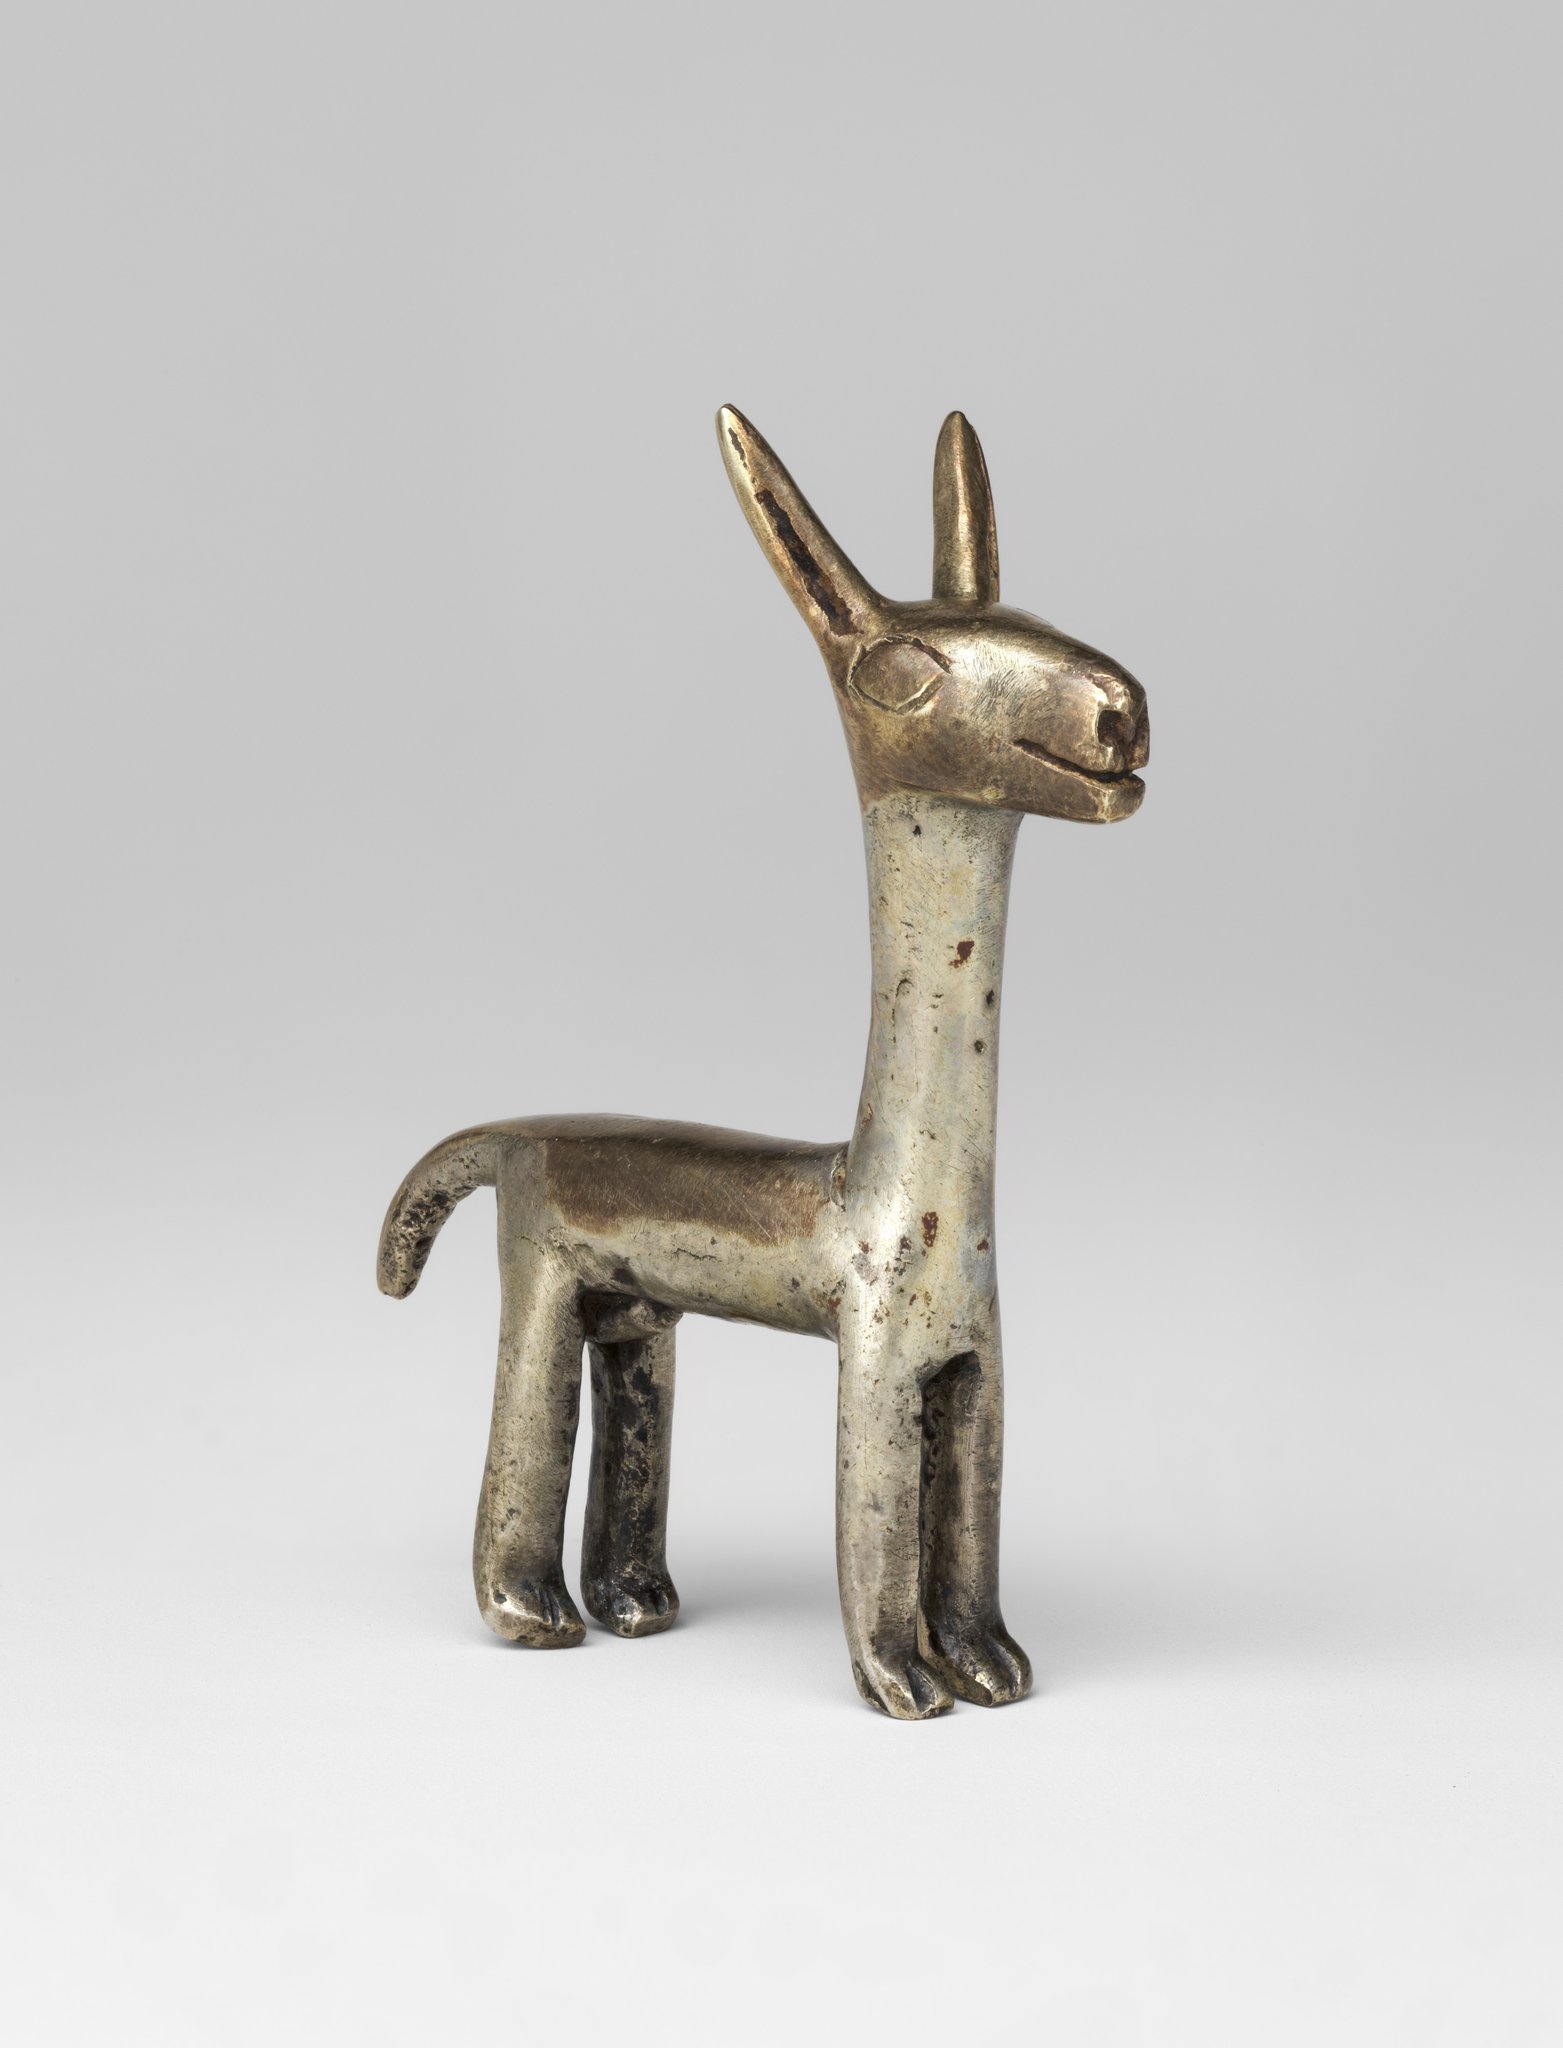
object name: figure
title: Miniature camelid effigy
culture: inca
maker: inca artist(s)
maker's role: artist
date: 1400-1535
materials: copper alloy, gold, silver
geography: ecuador, peru, bolivia, chile, or argentina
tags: animals